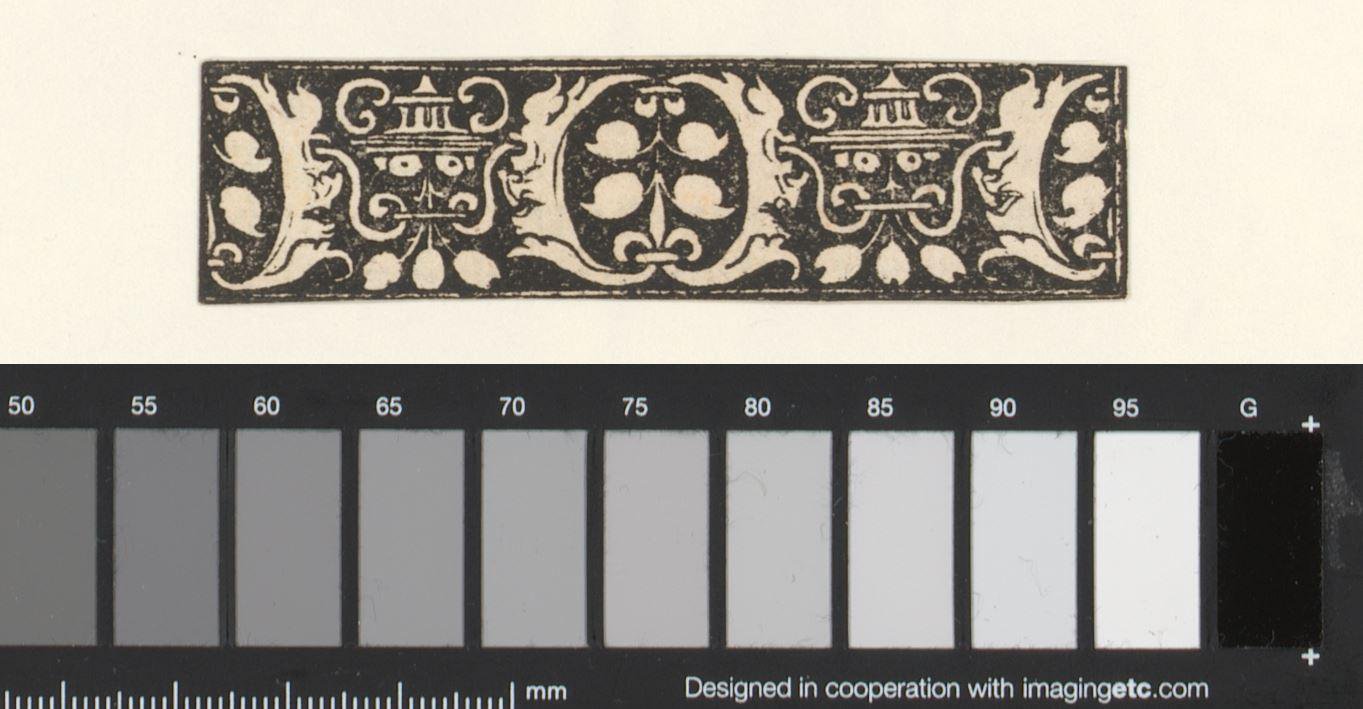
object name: album leaf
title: Ornament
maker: Anonymous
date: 1514-1532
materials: paper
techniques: letterpress printing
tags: foliage ~ ornament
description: Deze prent is gebruikt als ornament in: Petrarca, Francesco. Von der Artzney bayder Glück, des guten und widerwertigen: unnd weß sich ain yeder inn Gelück und Unglück halten sol (...). Augsburg: Heinrich Steiner, 1532. Deze uitgave is ook bekend onder de titel 'Trostspiegel in Glück und Unglück'.